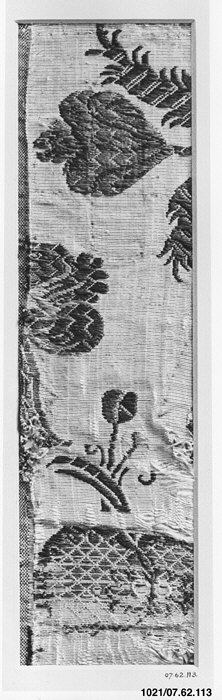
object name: piece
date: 1501-1700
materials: metal thread, silk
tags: flowers,leaves